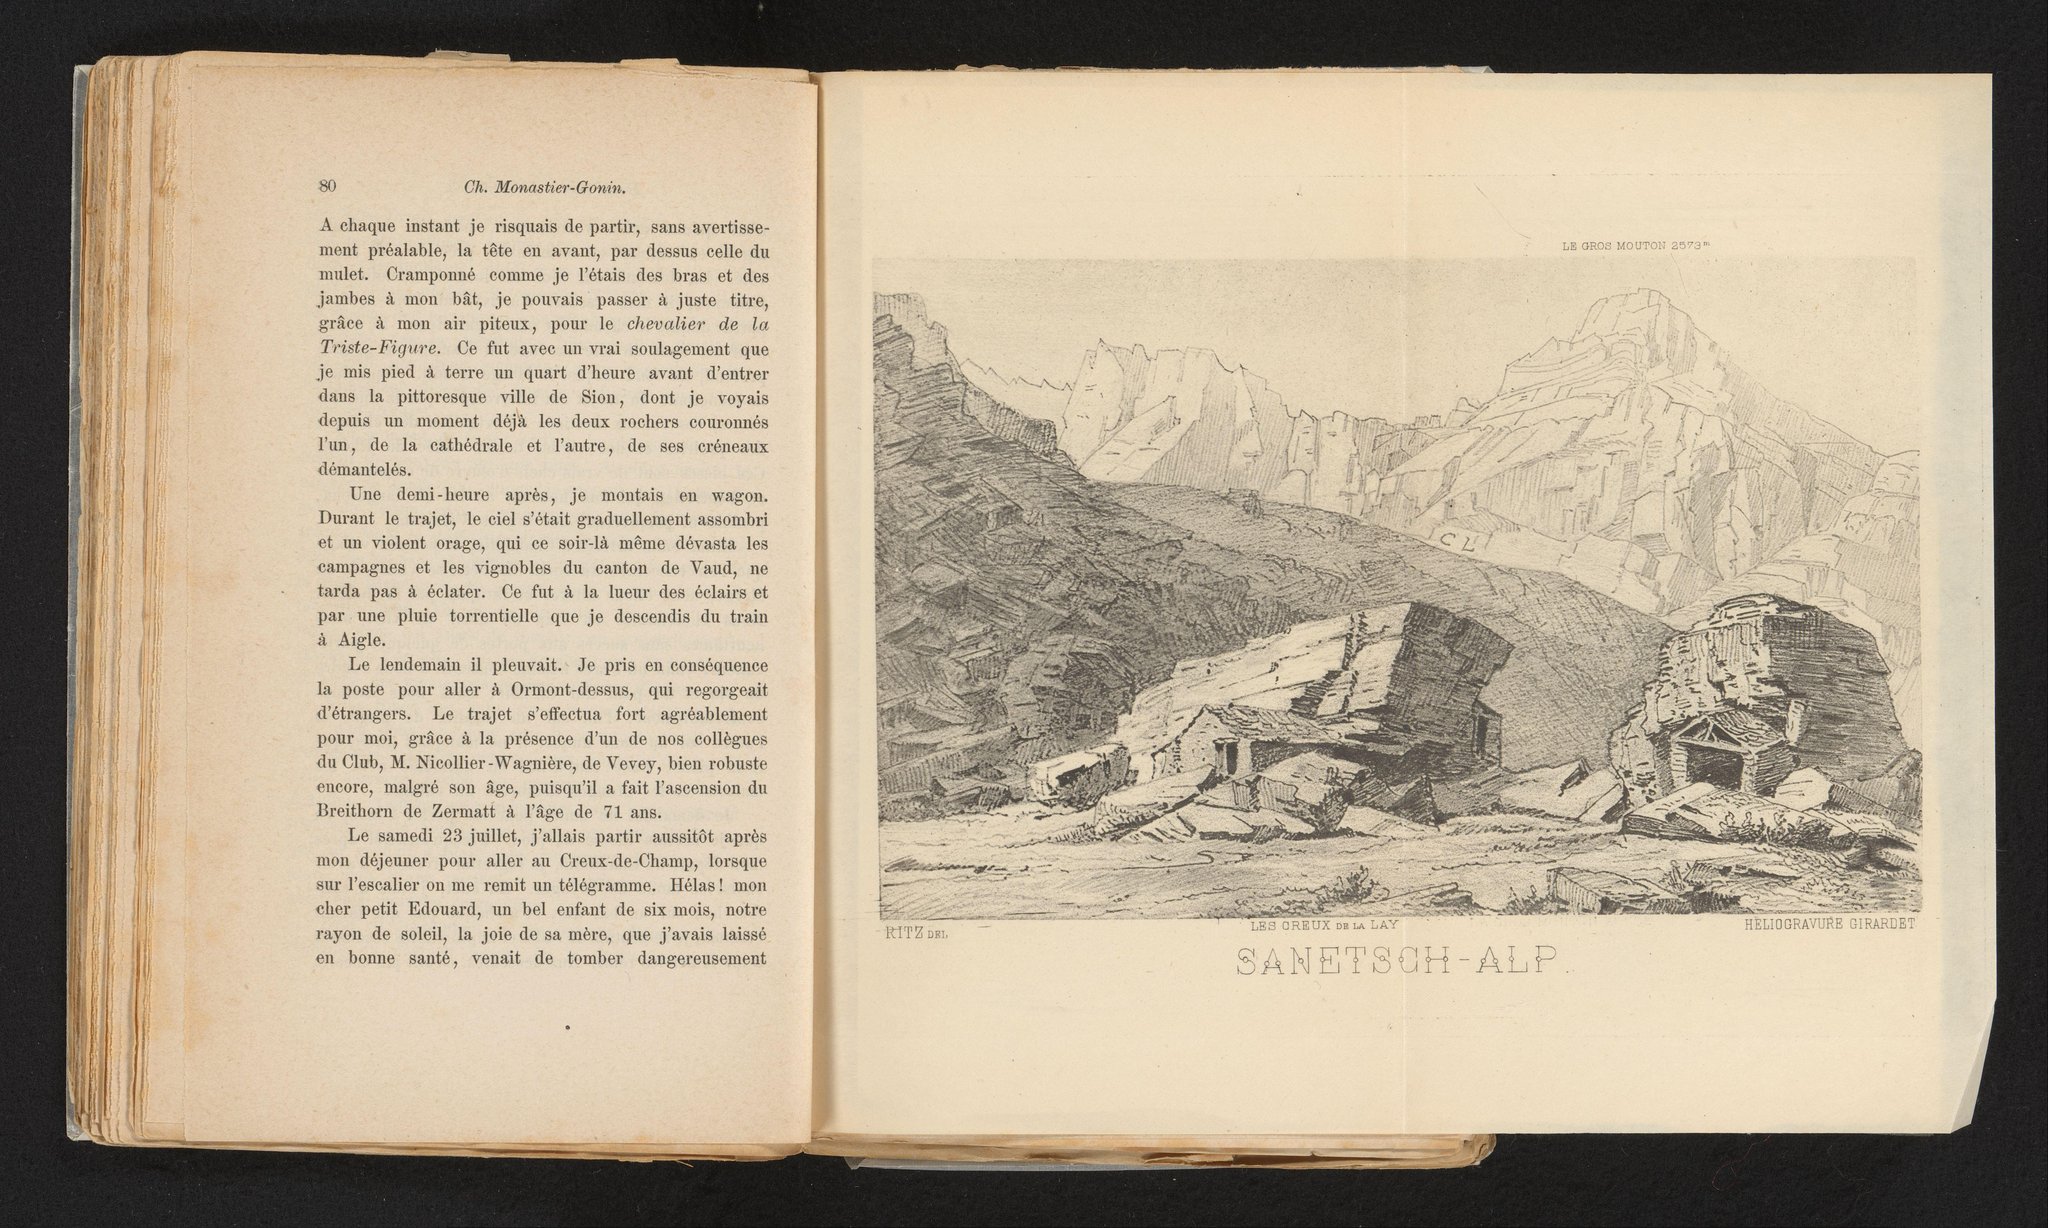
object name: reproduction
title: Reproductie van een tekening van een gezicht op Col du Sanetsch in de Alpen, Zwitserland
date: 1877-1882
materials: paper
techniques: photoaquatint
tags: mountain-range, snow peaks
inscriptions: inscription: ‘LE GROS MOUTIN 2573m/ LES CREUX de la LAY’